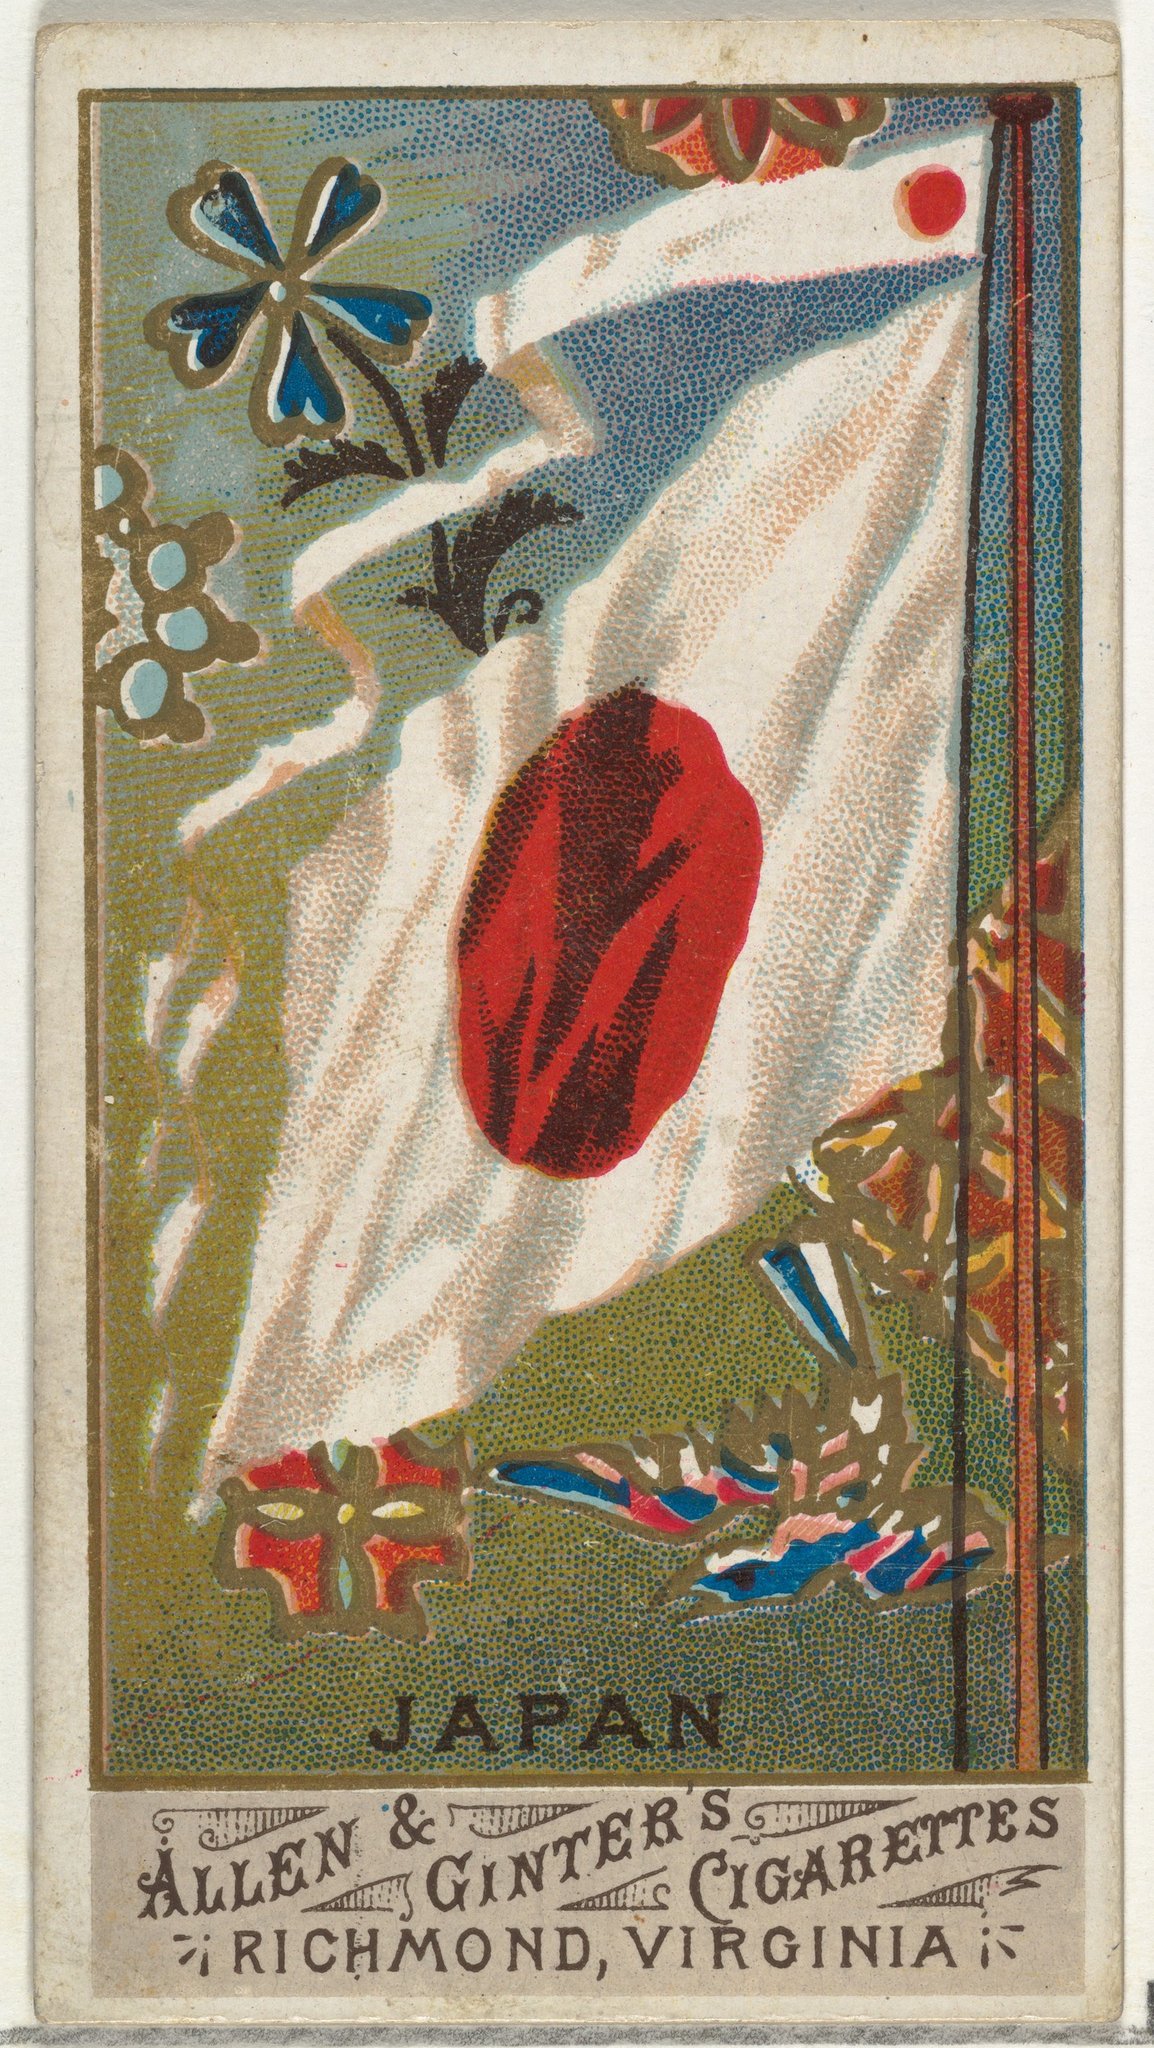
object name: print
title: Japan, from Flags of All Nations, Series 1 (N9) for Allen & Ginter Cigarettes Brands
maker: allen & ginter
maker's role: publisher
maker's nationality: american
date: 1887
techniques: color lithograph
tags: flags